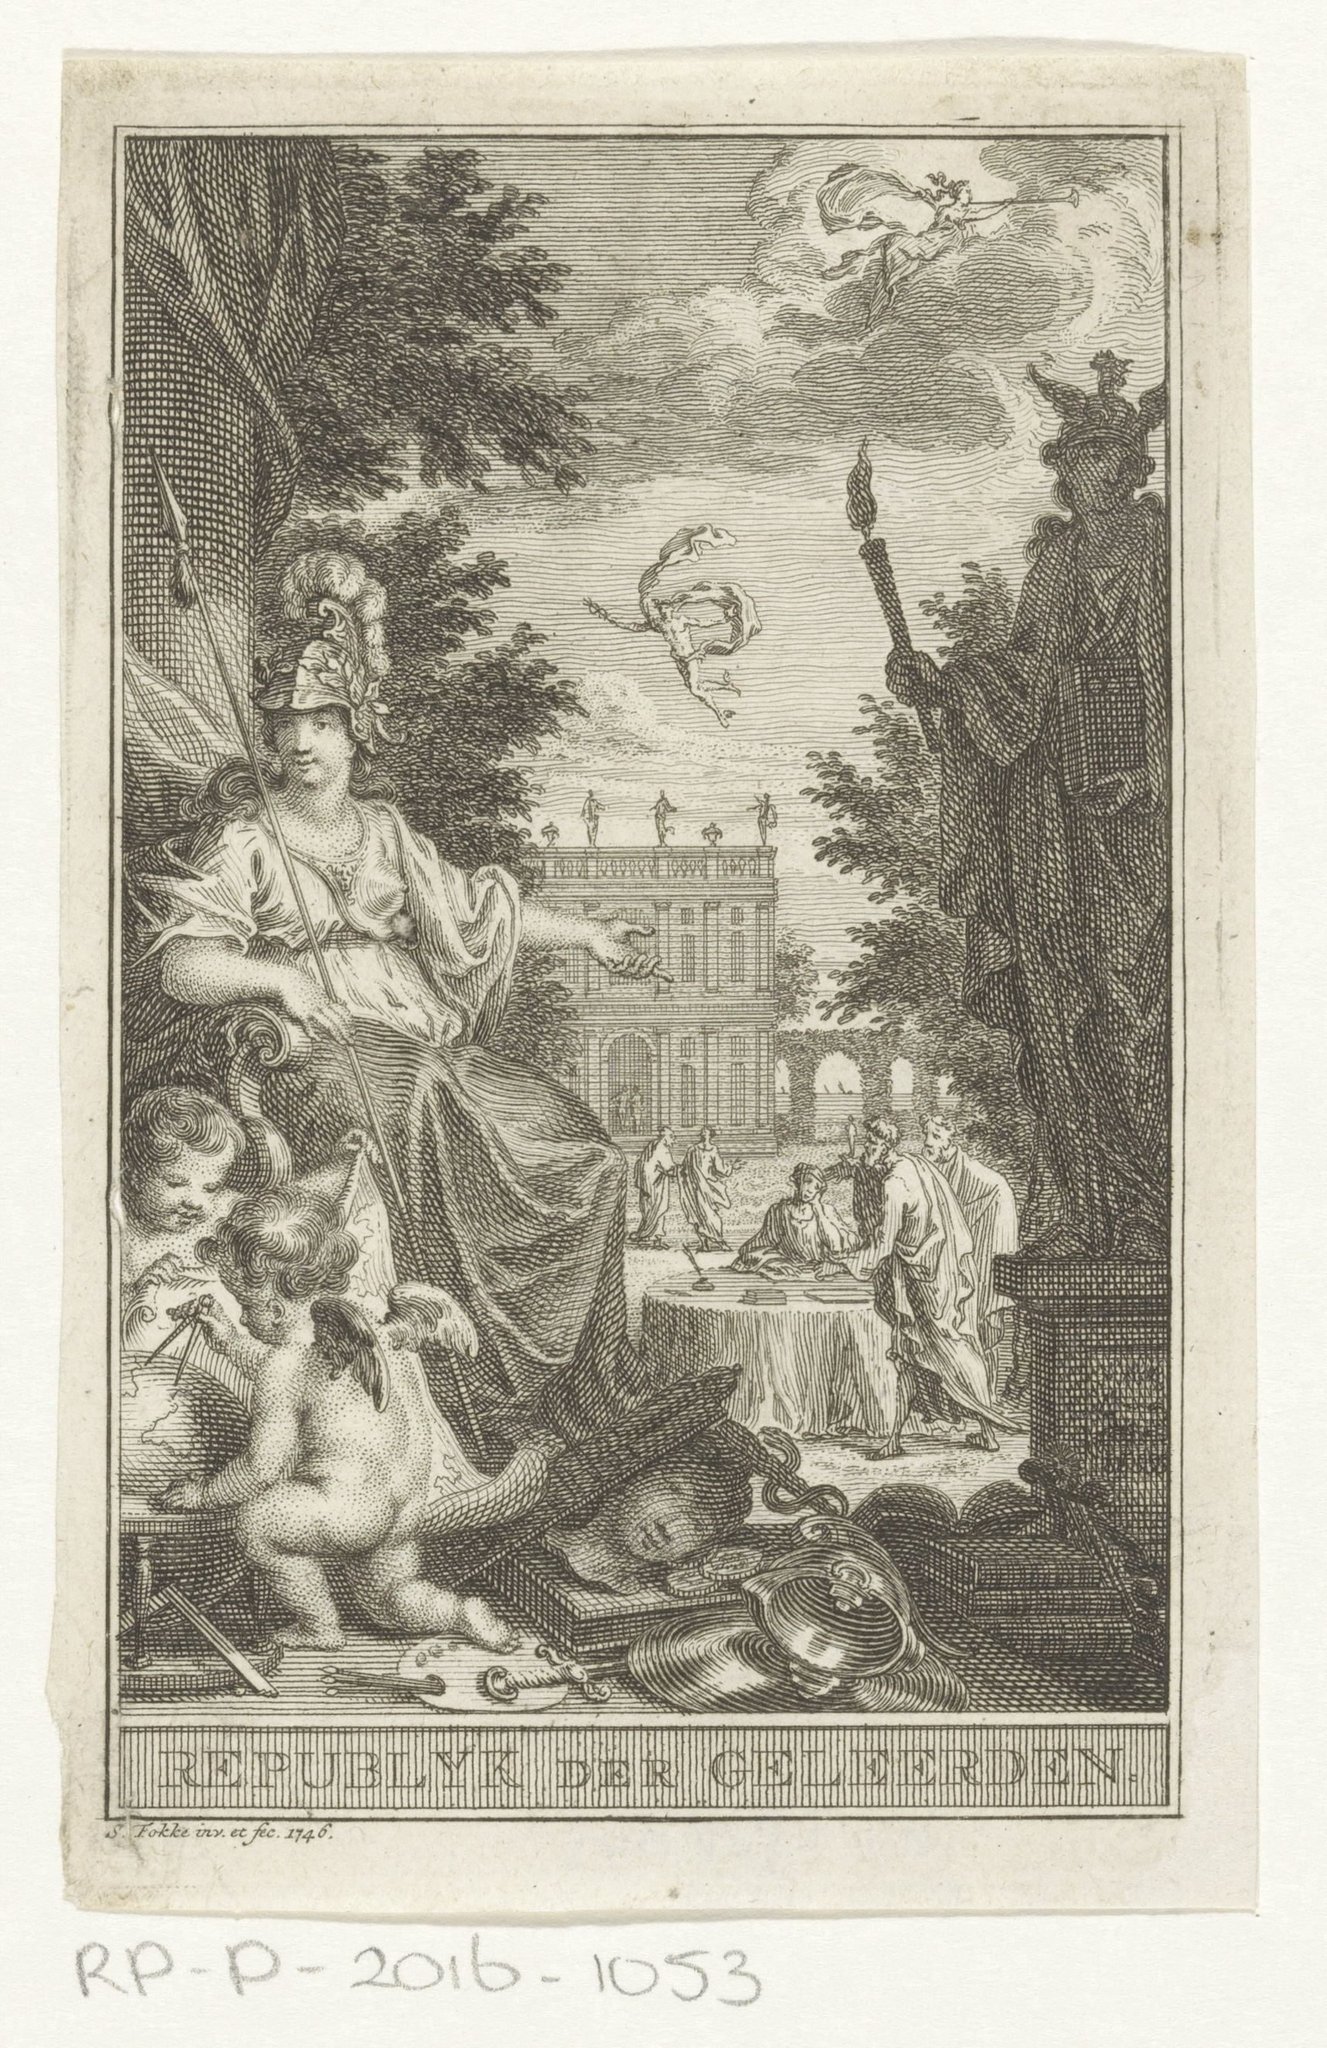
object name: titelblad, titelpagina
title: Minerva als patrones van wetenschap en kunsten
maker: simon fokke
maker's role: draughtsman, print maker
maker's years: 1712-1784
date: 1746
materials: paper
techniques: engraving, etching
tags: scholar, philosopher, specific aspects, allegorical aspects of minerva; minerva as patroness, cupids: 'amores', 'amoretti', 'putti'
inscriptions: collector's mark: Lugt 2228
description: Minerva wordt omringd door attributen van wetenschap en kunsten en zit in het gezelschap van twee putti die met passer en landkaart een wereldbol bestuderen. Ze wijst op de achtergrond waar figuren in klassieke kledij op een plein staan. Rechts van haar staat een gehelmde allegorische figuur op sokkel met een fakkel en boek in de handen.